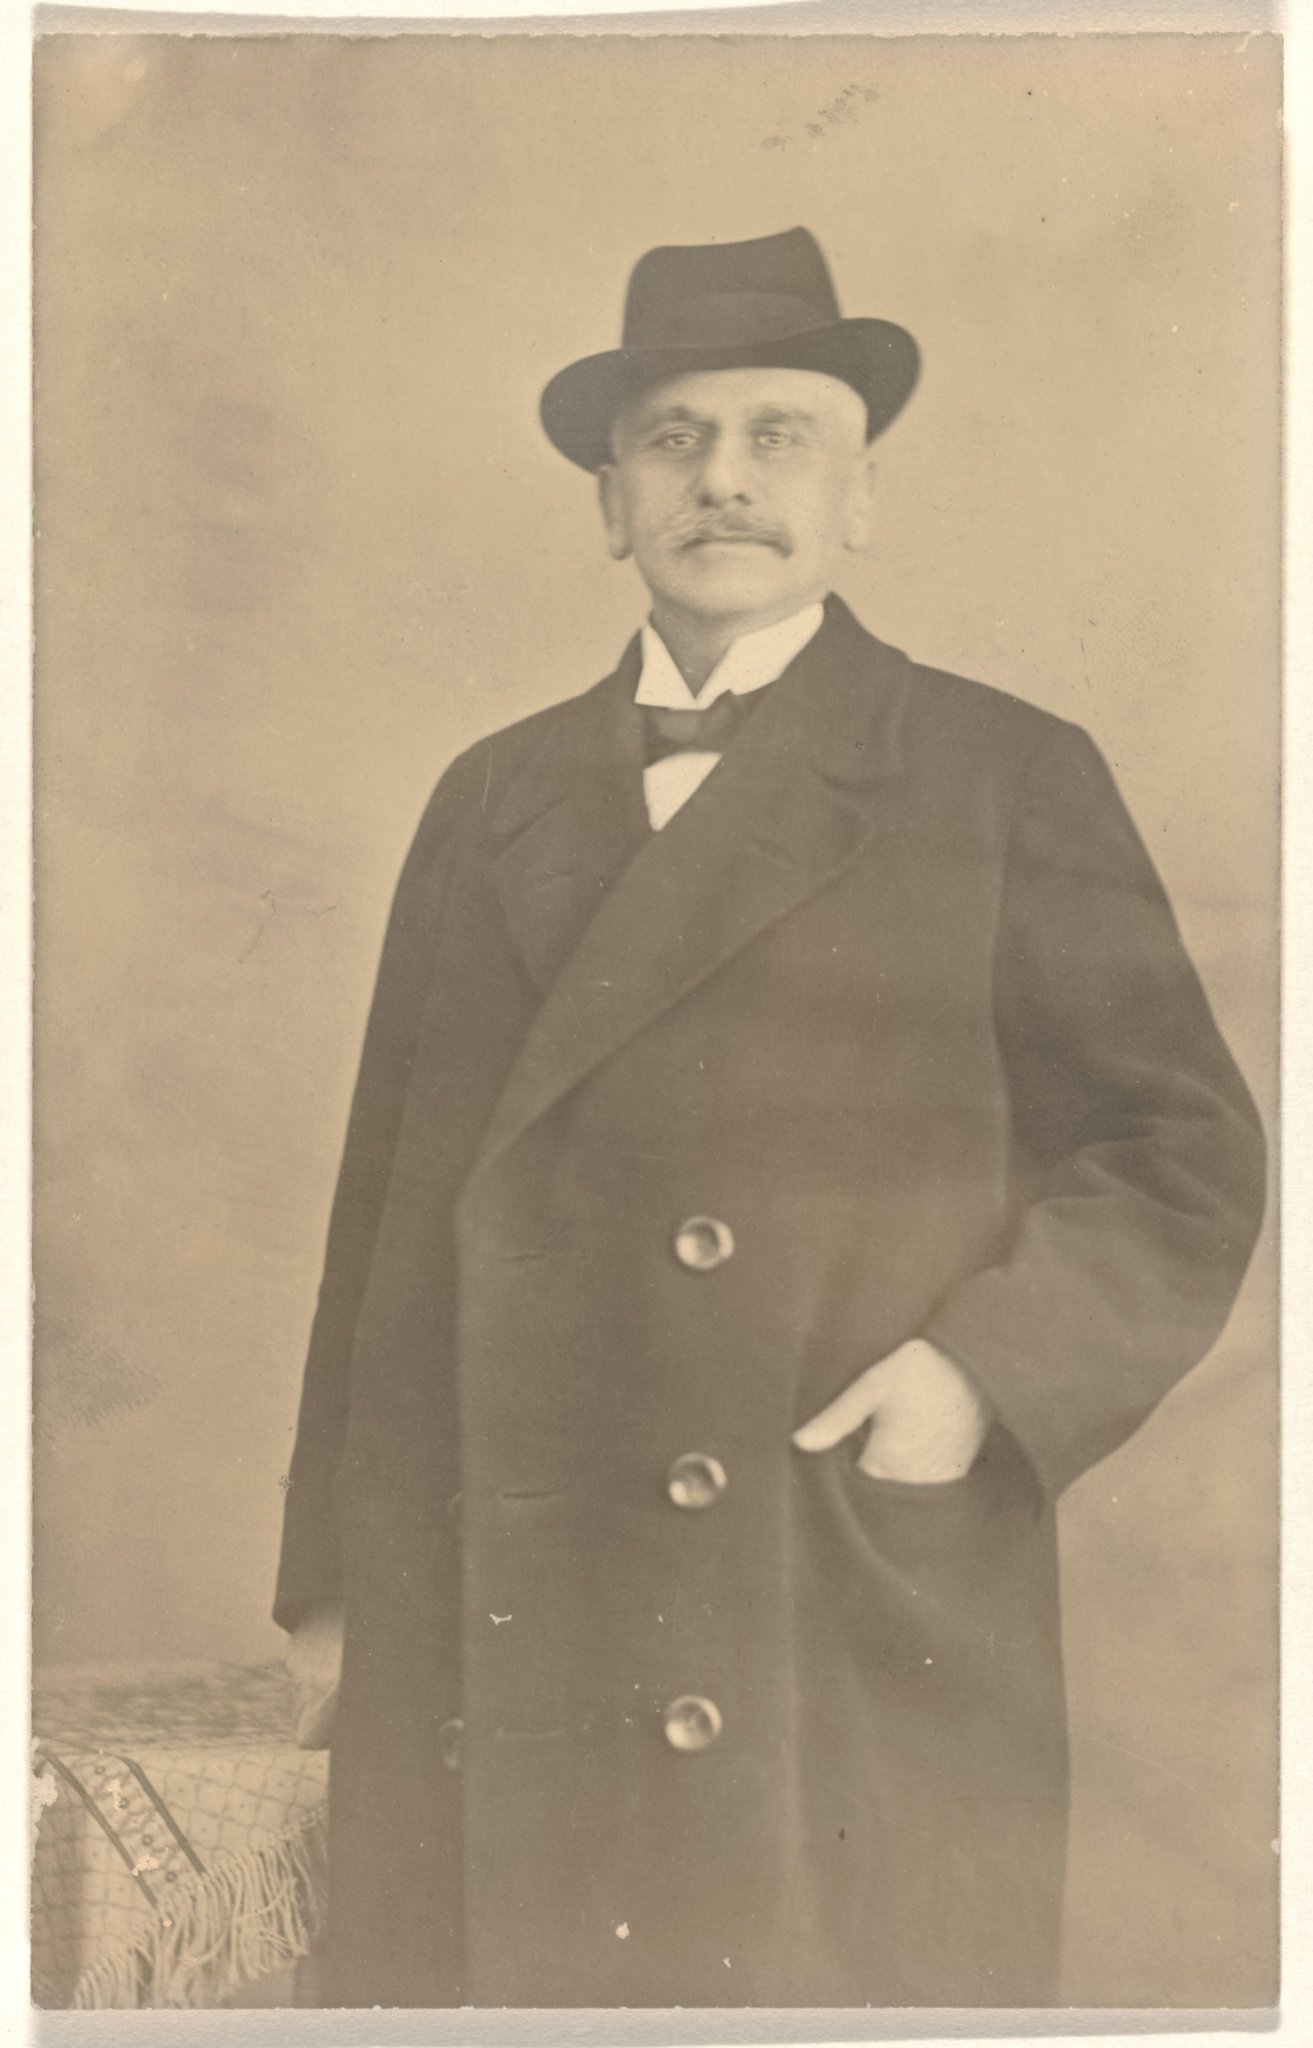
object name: photograph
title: Portret van Meir Wachenheimer, met hoed op het hoofd en hand in de jaszak van een jas met drie knopen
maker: Anonymous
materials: photographic support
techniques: gelatin silver print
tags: meir wachenheimer, straatsburg (frankrijk)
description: Portret van Meir Wachenheimer, met hoed op het hoofd en hand in de jaszak van een jas met drie knopen.